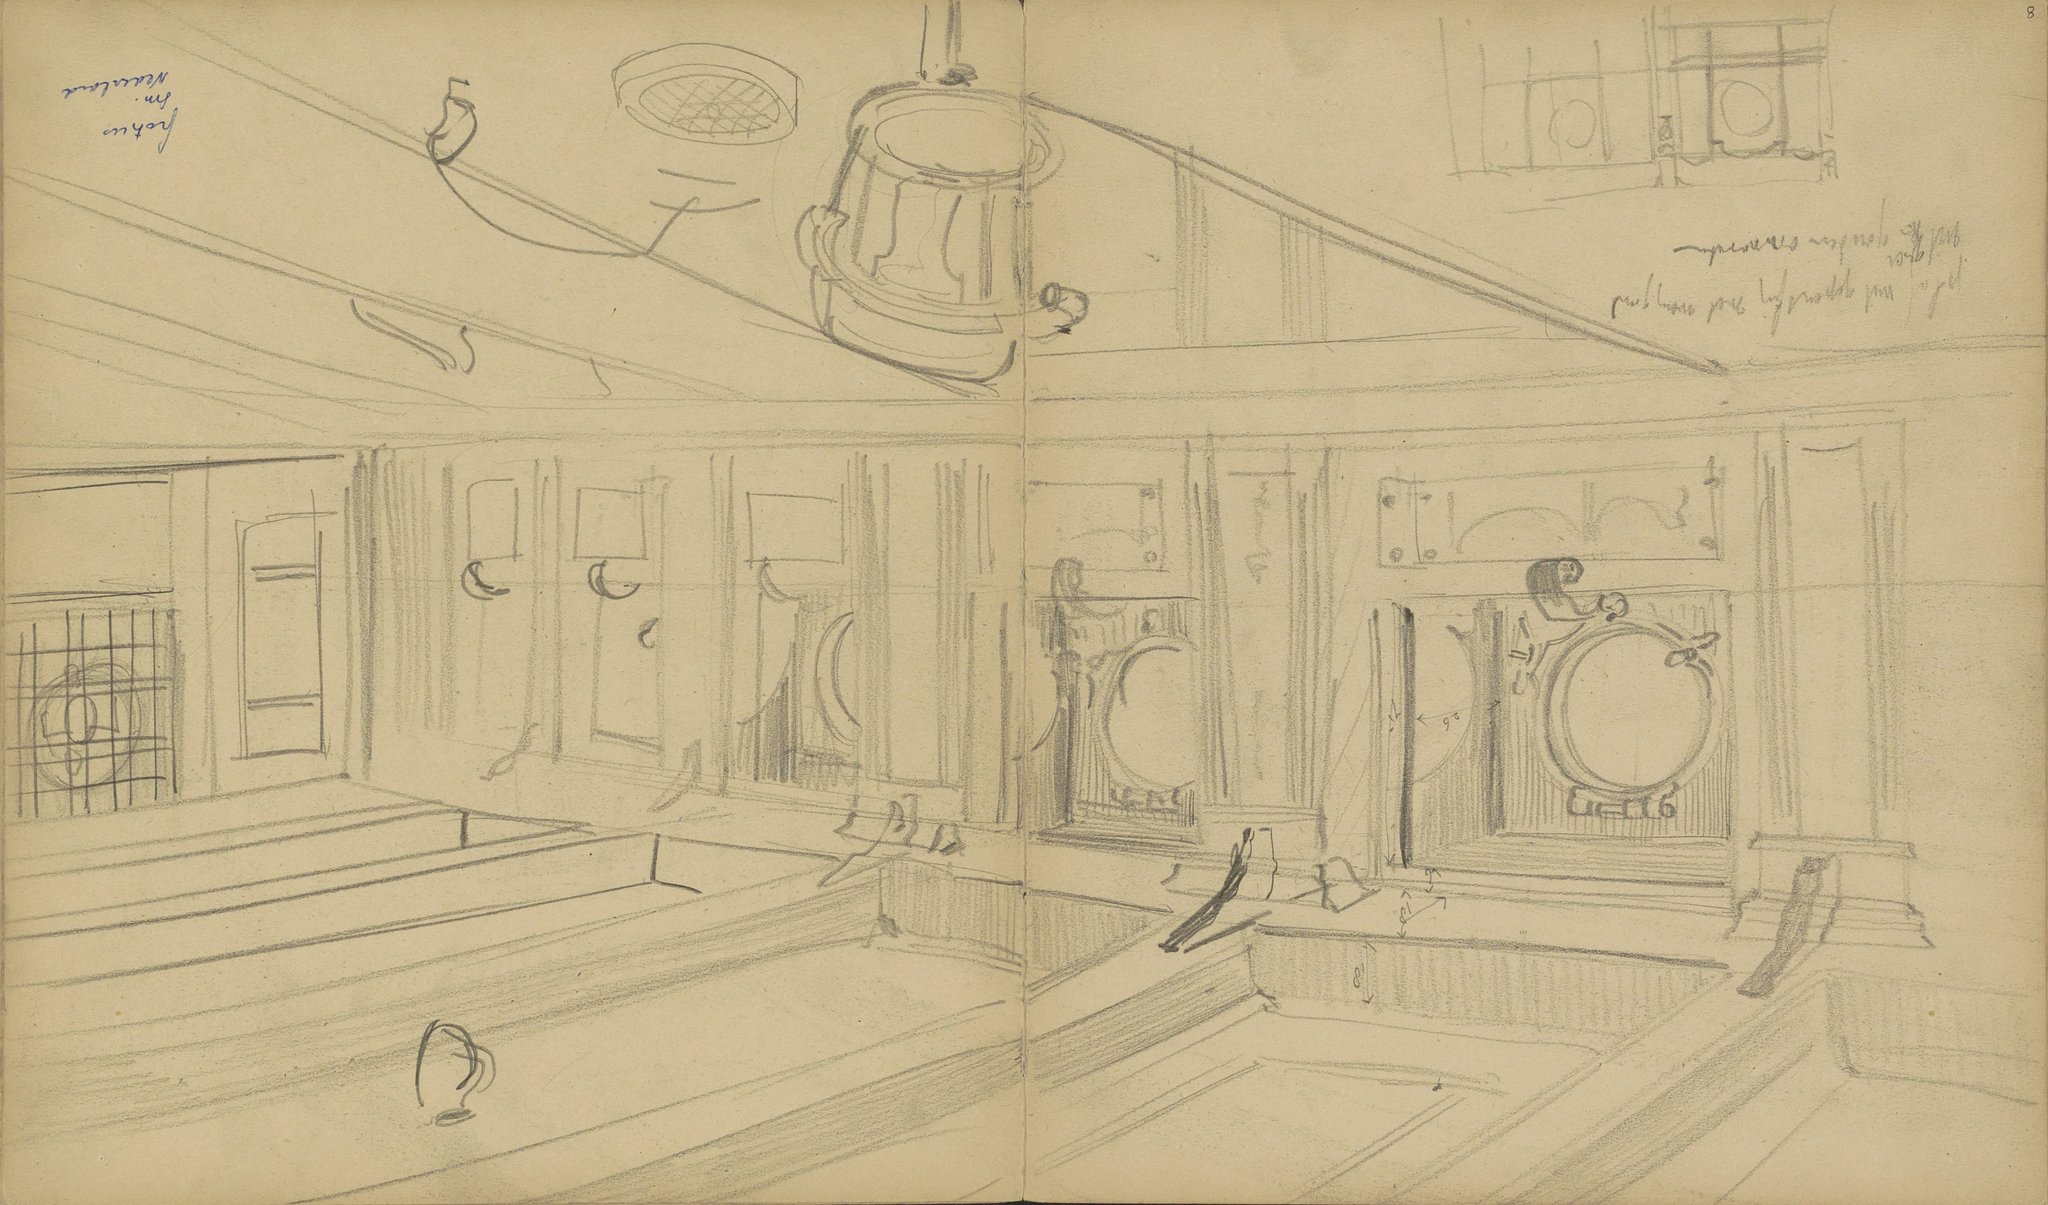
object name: sketchbook leaf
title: Ontwerp voor een salon van het schip 'Grotius'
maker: carel adolph lion cachet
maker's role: draughtsman, print maker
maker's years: 1864-1945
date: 1906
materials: paper, pencil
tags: interior ~ representation of a building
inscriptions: annotation: ‘plat met gepers[...] met [...] goud/ [...] gouden ornamenten’, annotation: ‘Grotius/ sm/ Nederland’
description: Blad 7 verso en 8 recto uit een schetsboek met 27 bladen.